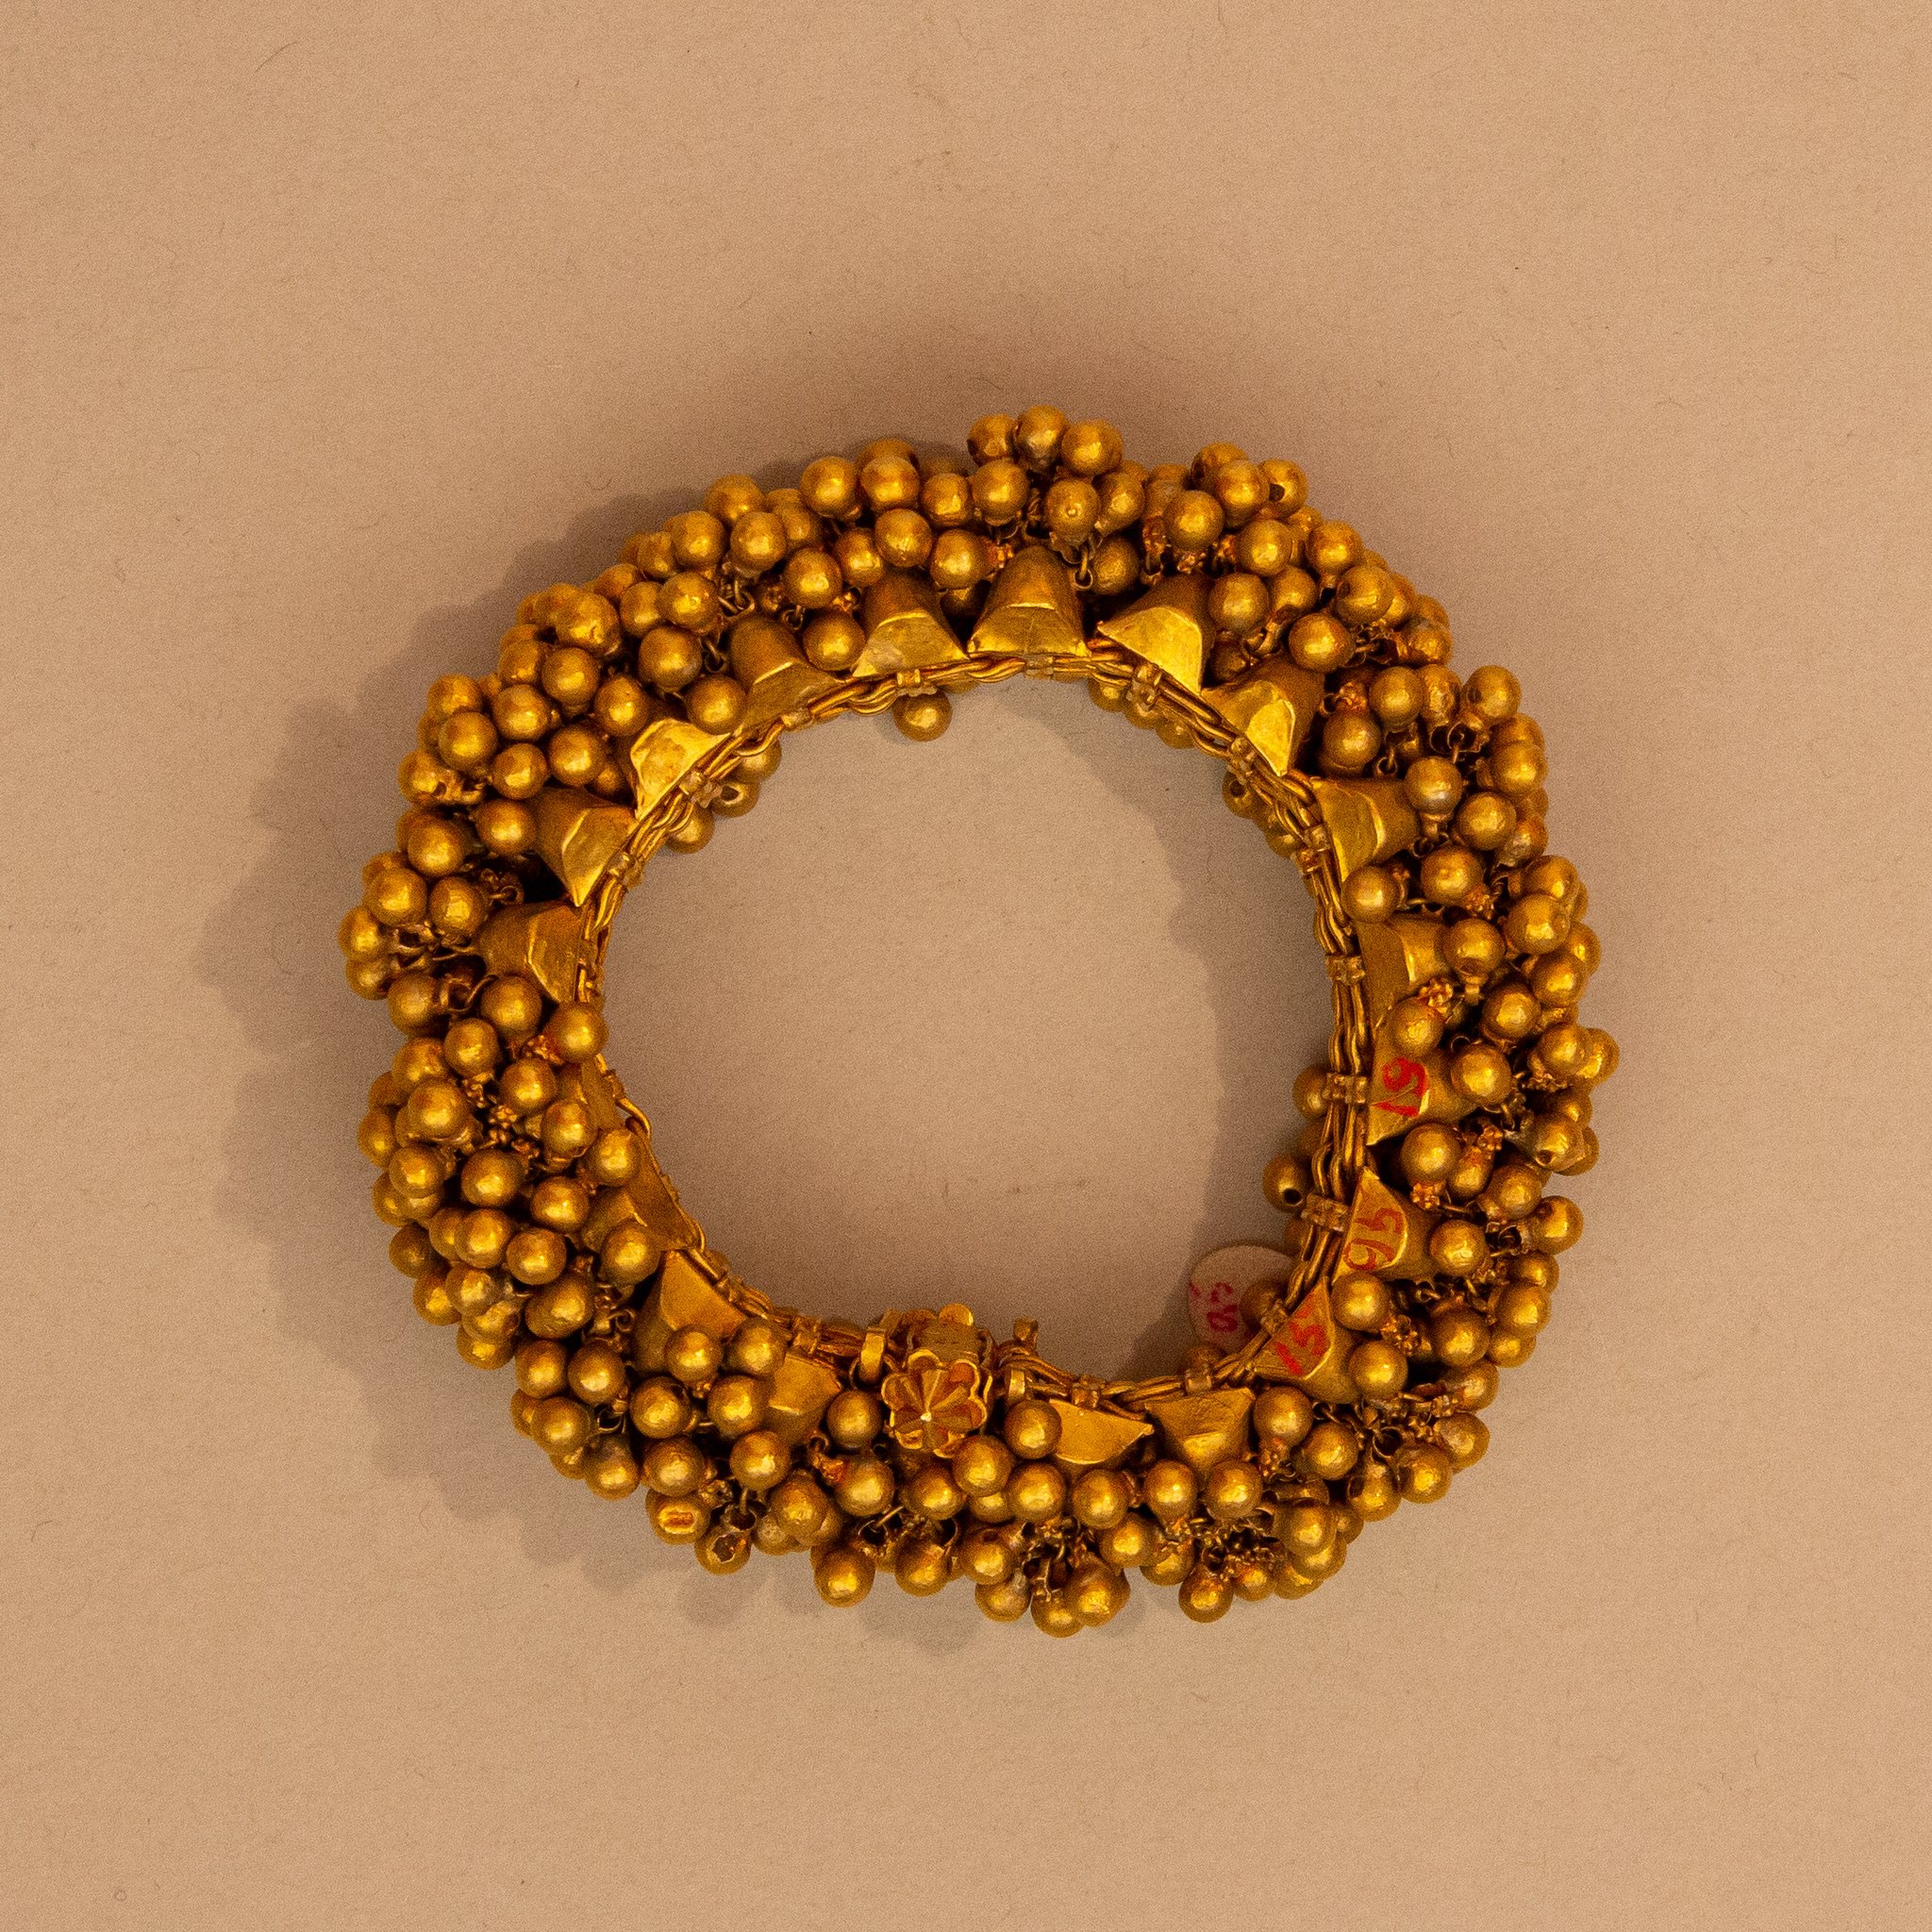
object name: anklet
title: Anklet (Paizeb), One of a Pair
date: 1801-1900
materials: gold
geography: india